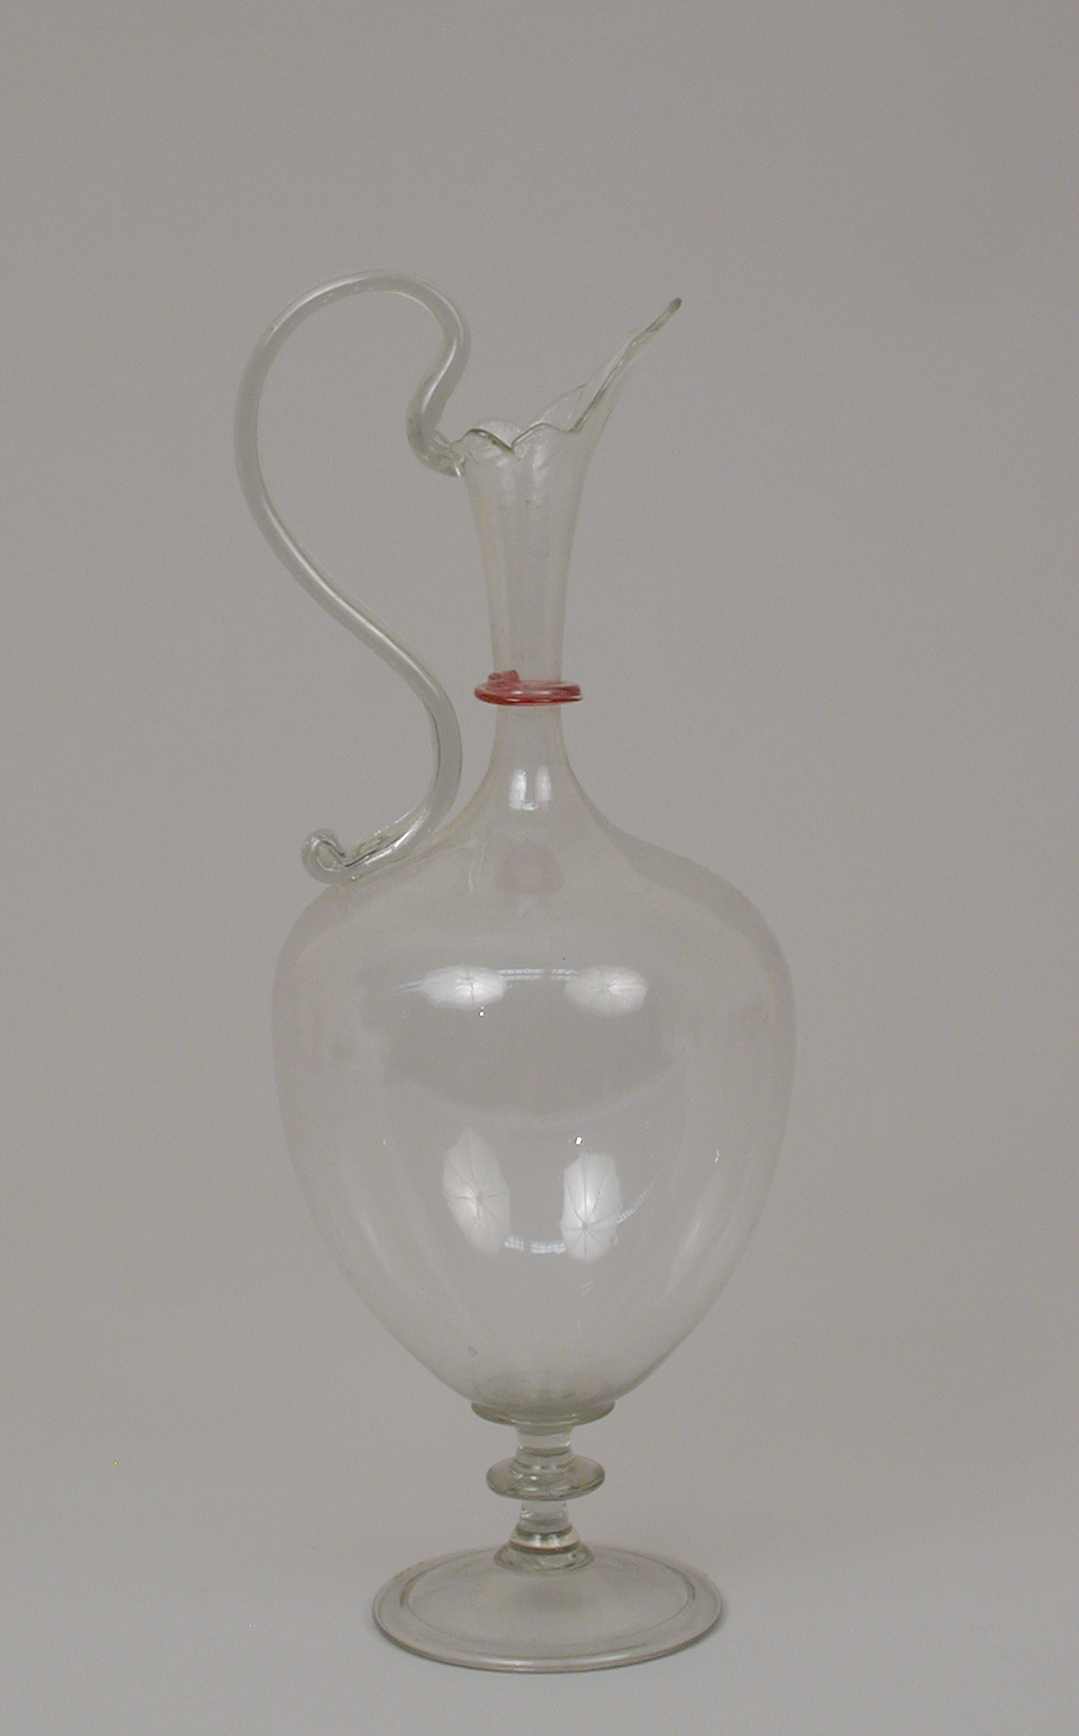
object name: ewer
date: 1860-1875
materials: glass